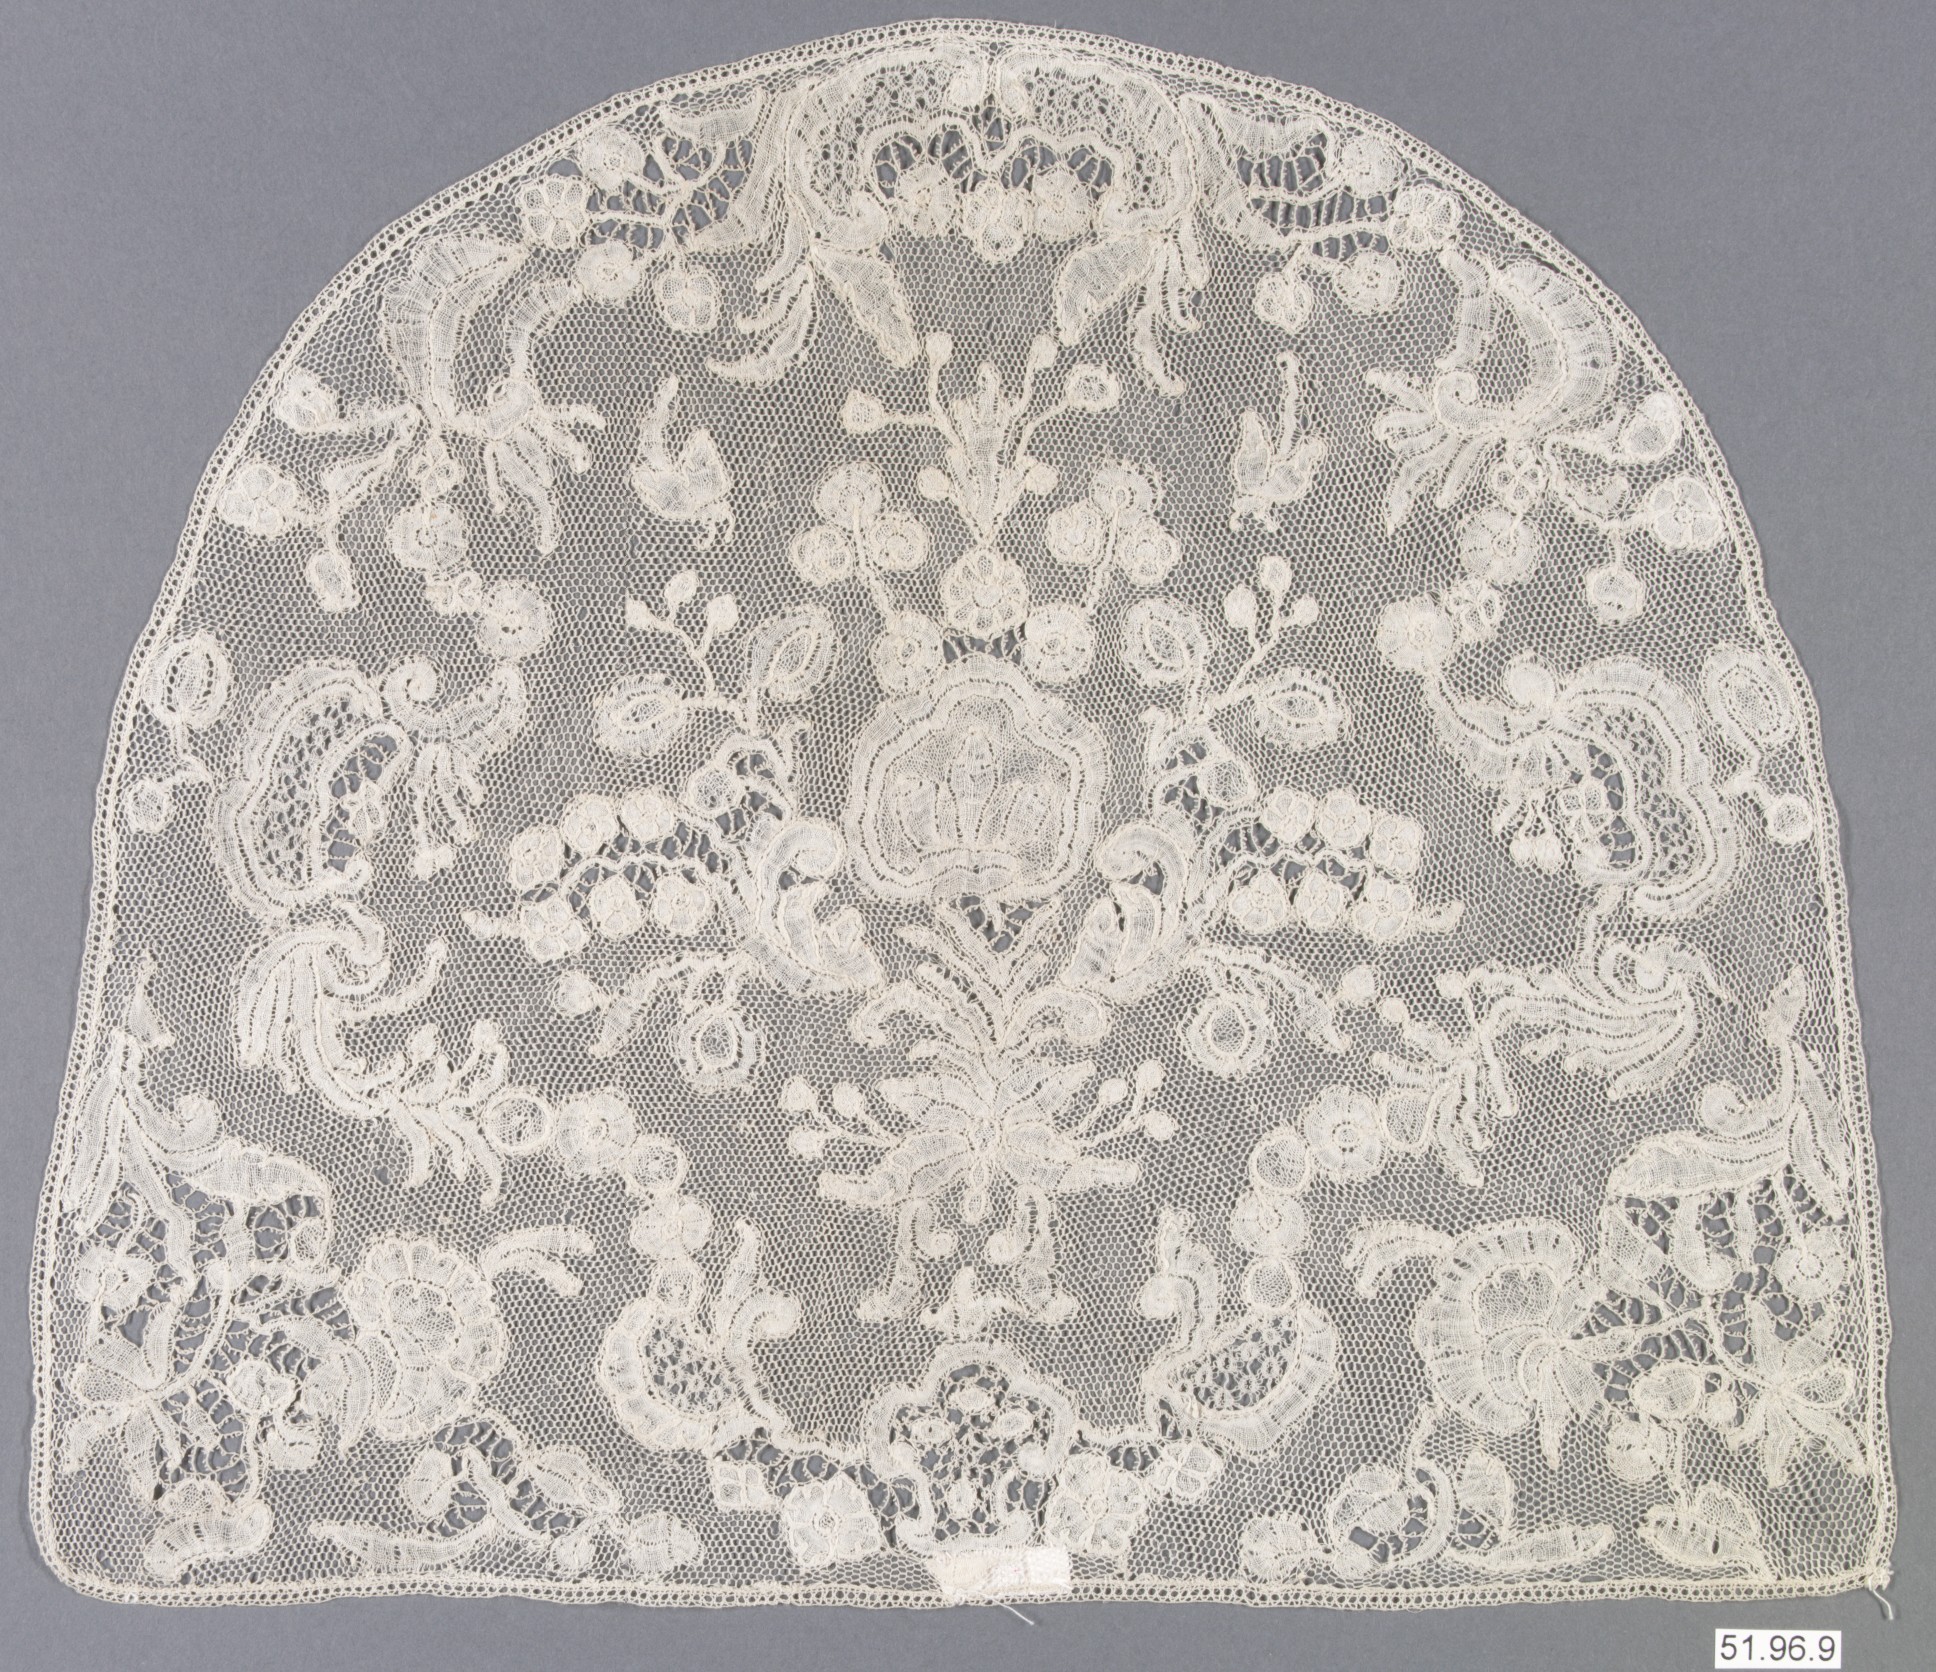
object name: cap crown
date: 1734-1766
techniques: lace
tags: flowers